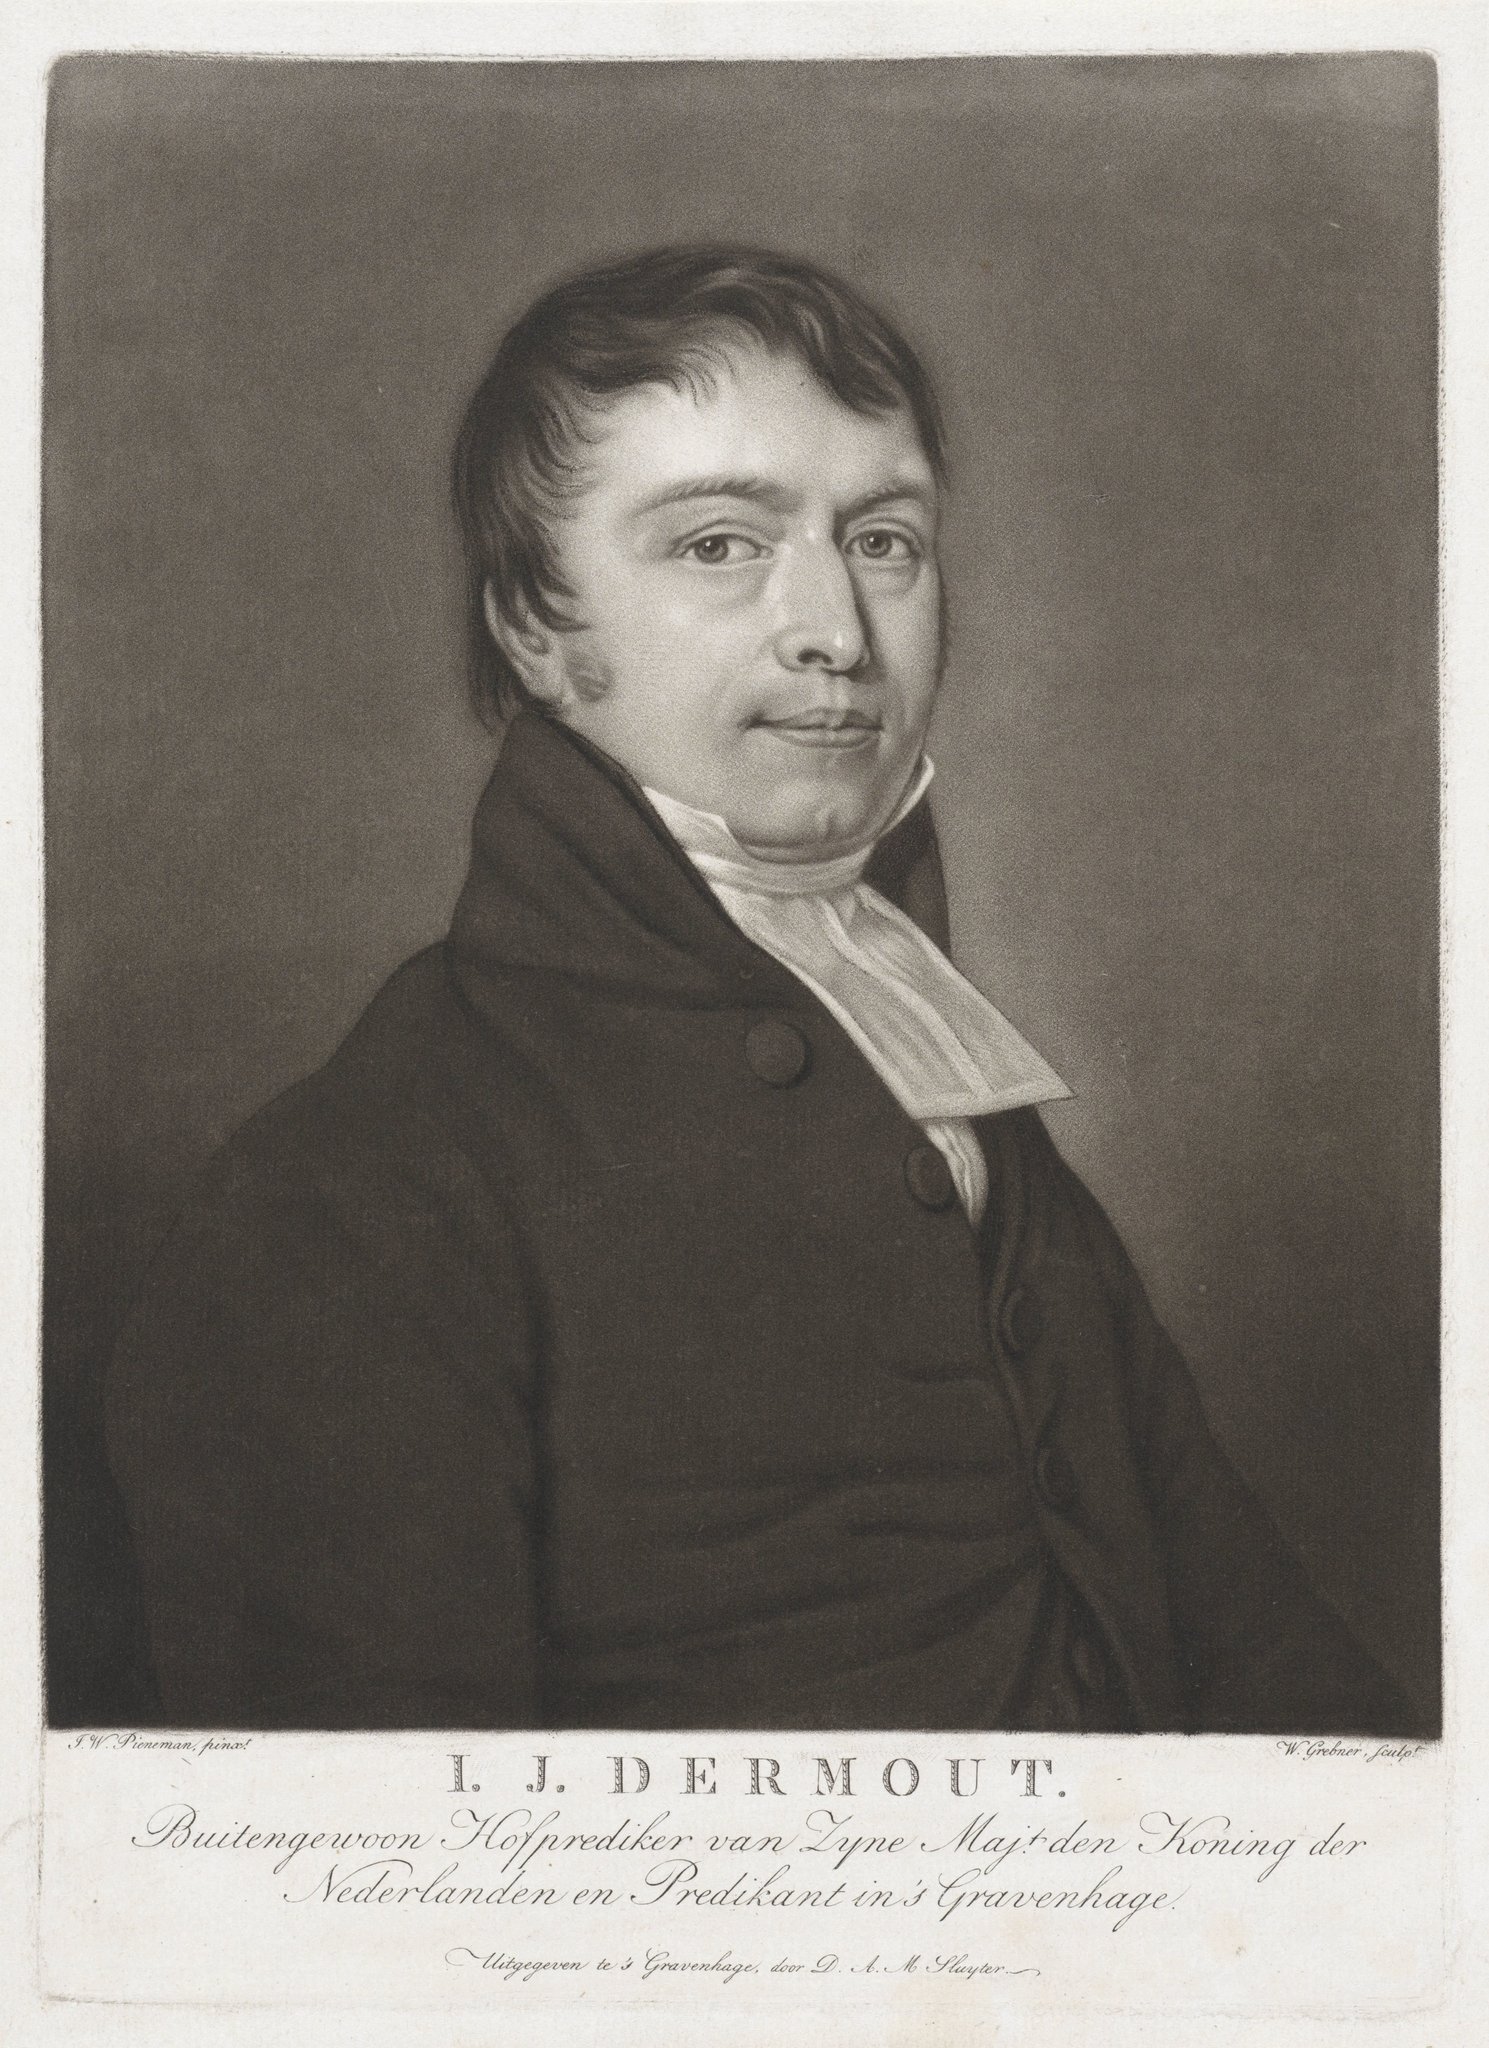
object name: print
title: Portret van Isaac Johannes Dermout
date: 1822-1866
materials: paper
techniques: engraving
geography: amsterdam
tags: hoorn (north holland), the hague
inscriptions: collector's mark: Lugt 2228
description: Isaac Johannes Dermout, hofprediker en hervormd predikant te Den Haag, gekleed in een donkere jas met een witte bef.